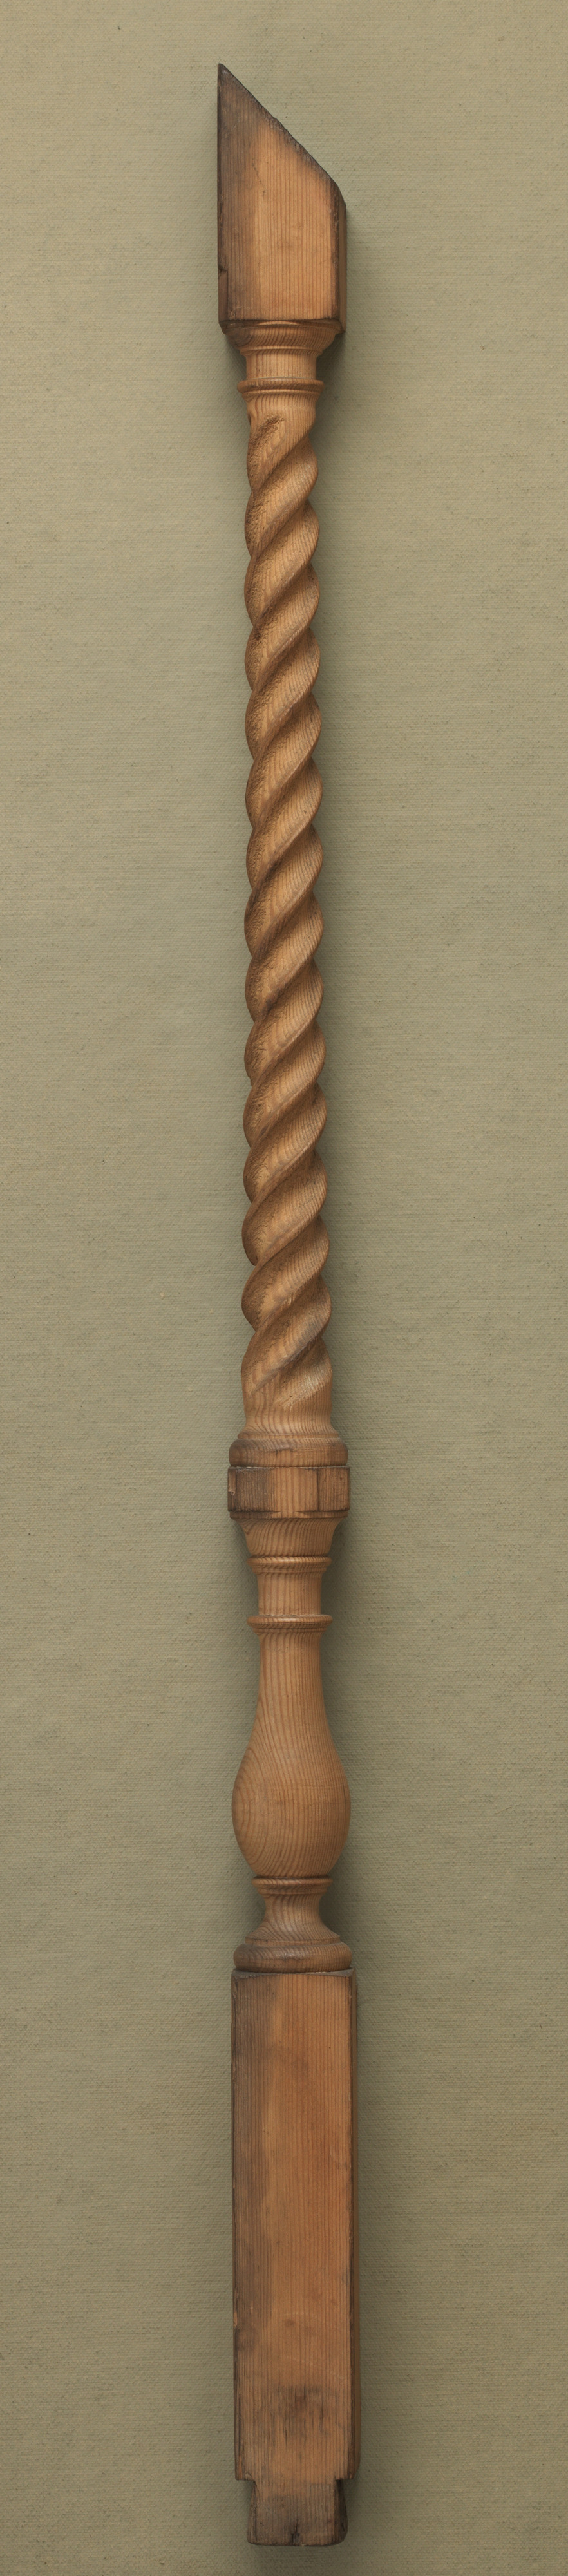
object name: baluster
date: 1734-1766